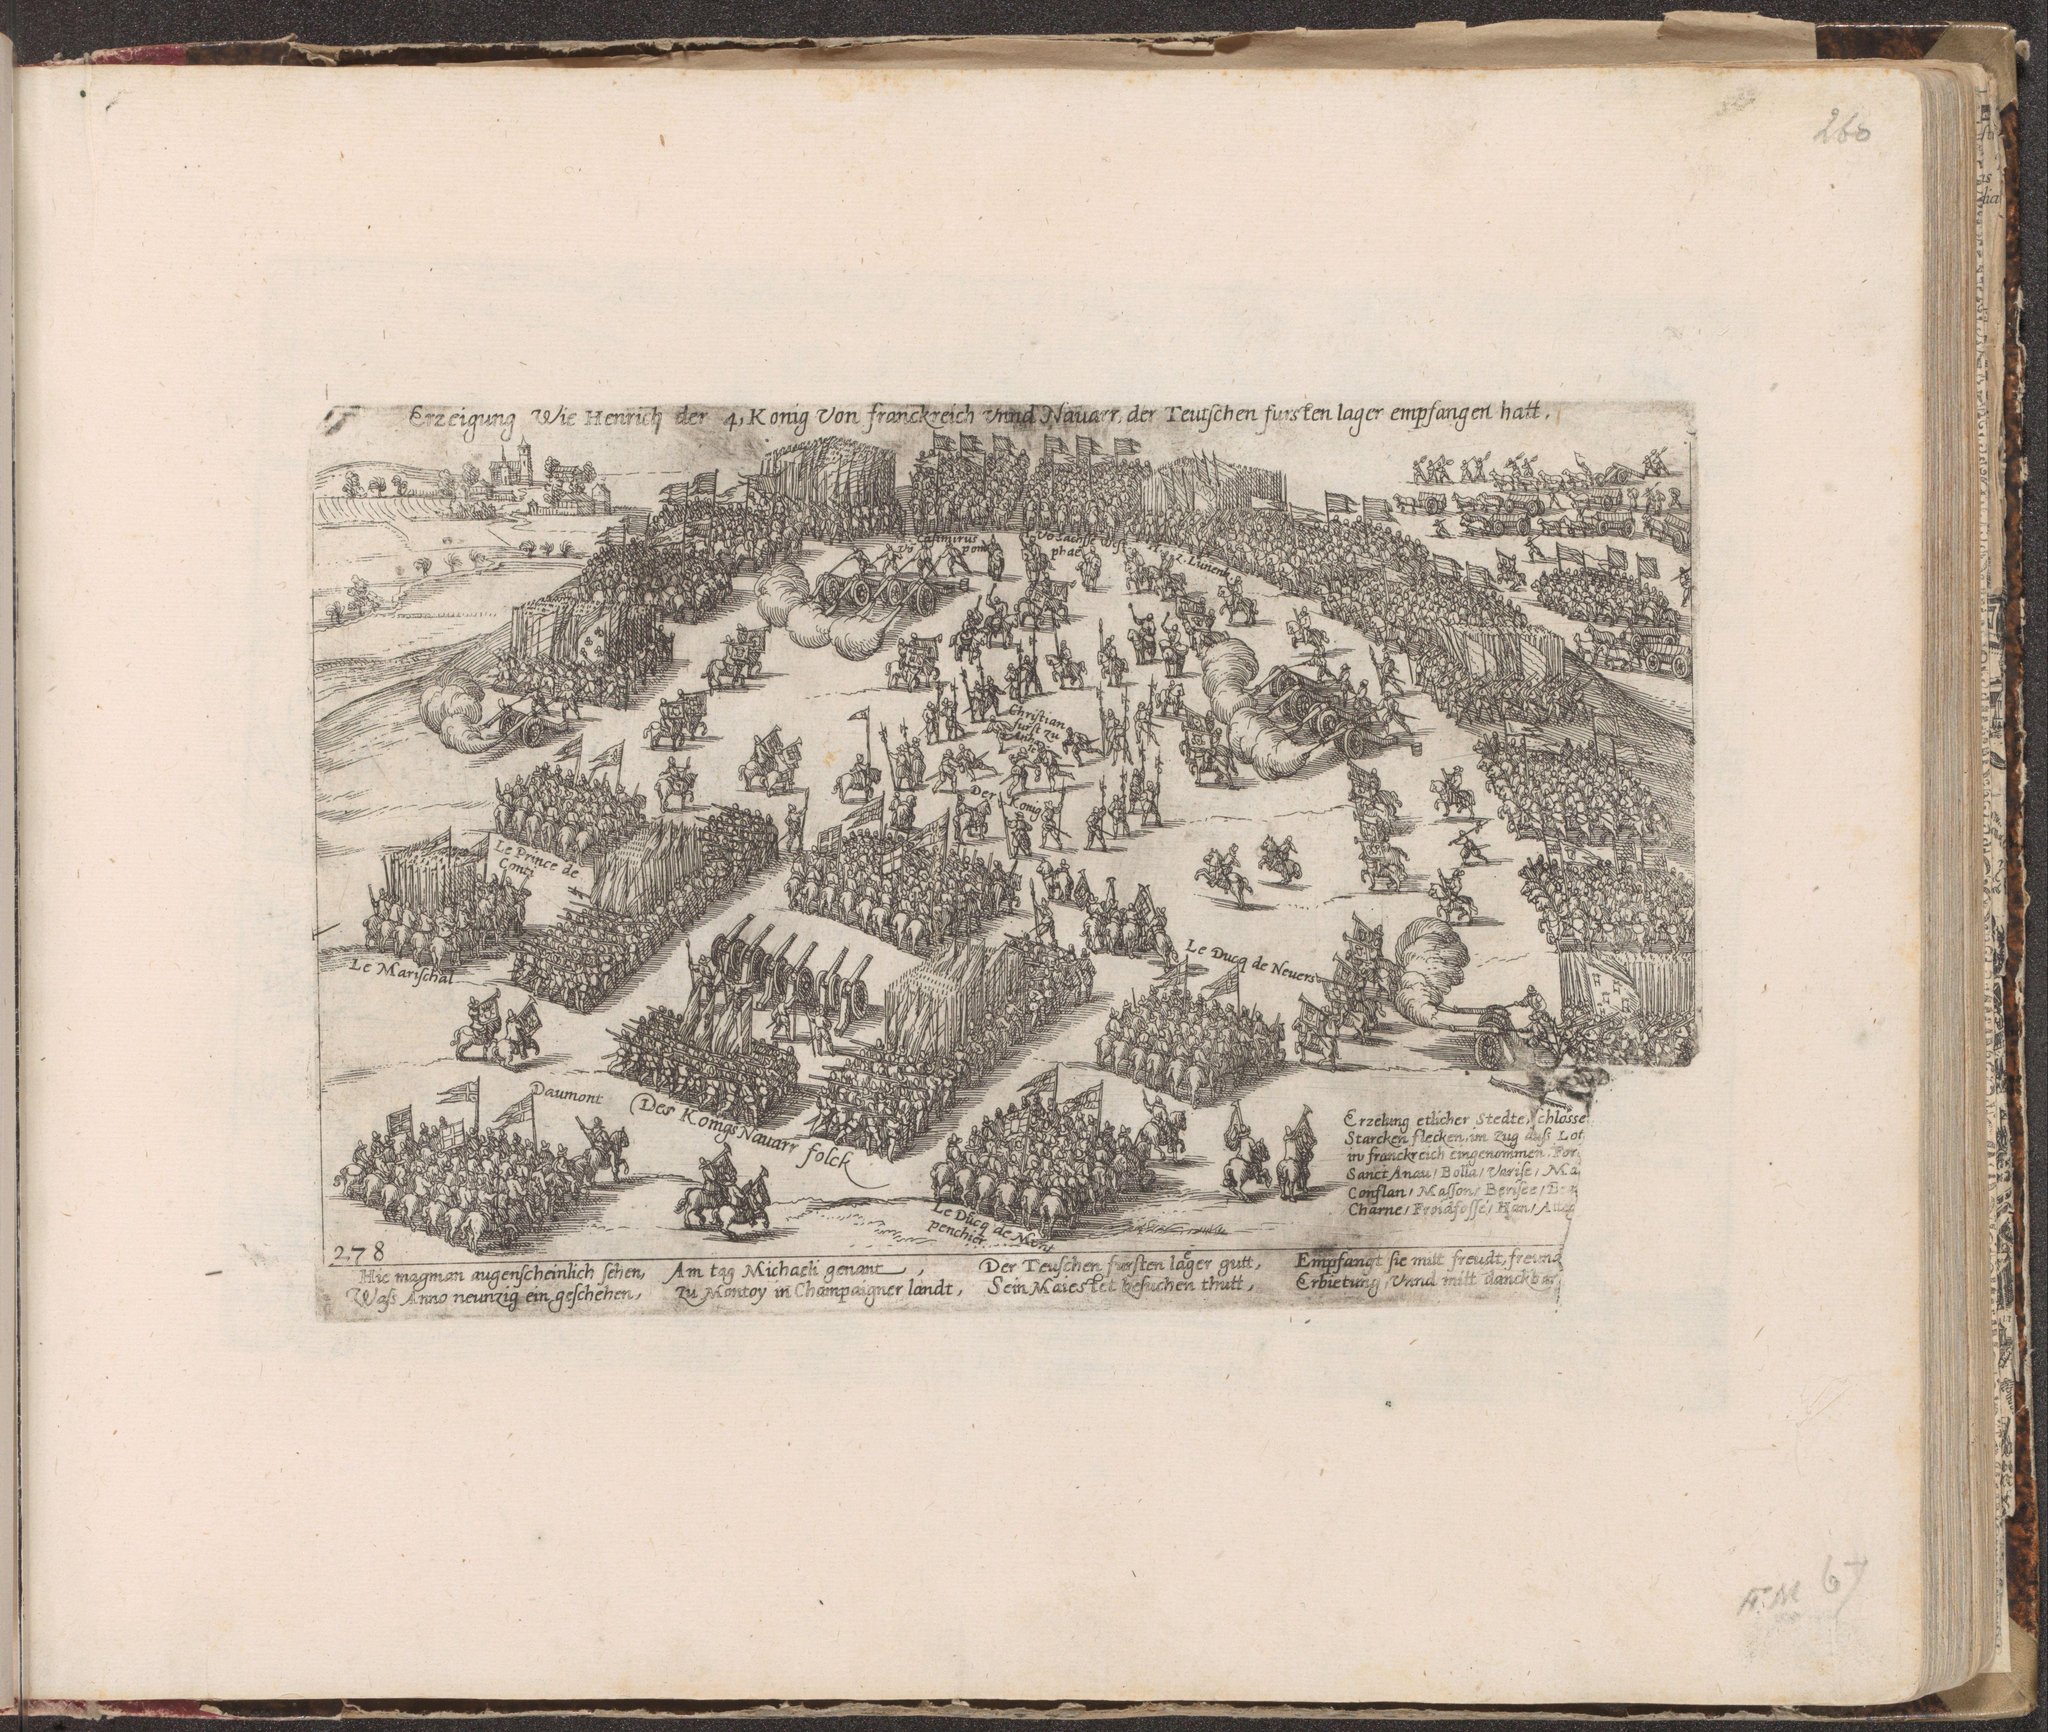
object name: album leaf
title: Bezoek van Hendrik IV aan het Duitse leger, 1591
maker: frans hogenberg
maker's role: print maker, publisher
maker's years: 1538-1590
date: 1591-1593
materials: paper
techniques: etching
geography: cologne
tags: paris, hendrik iv (koning van frankrijk en navarra)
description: Ontvangst van Hendrik IV en zijn troepen bij het Duitse leger, 1591. Met onderschrift van 8 regels in het Duits. Linksonder genummerd: 278. De prent maakt deel uit van een album.